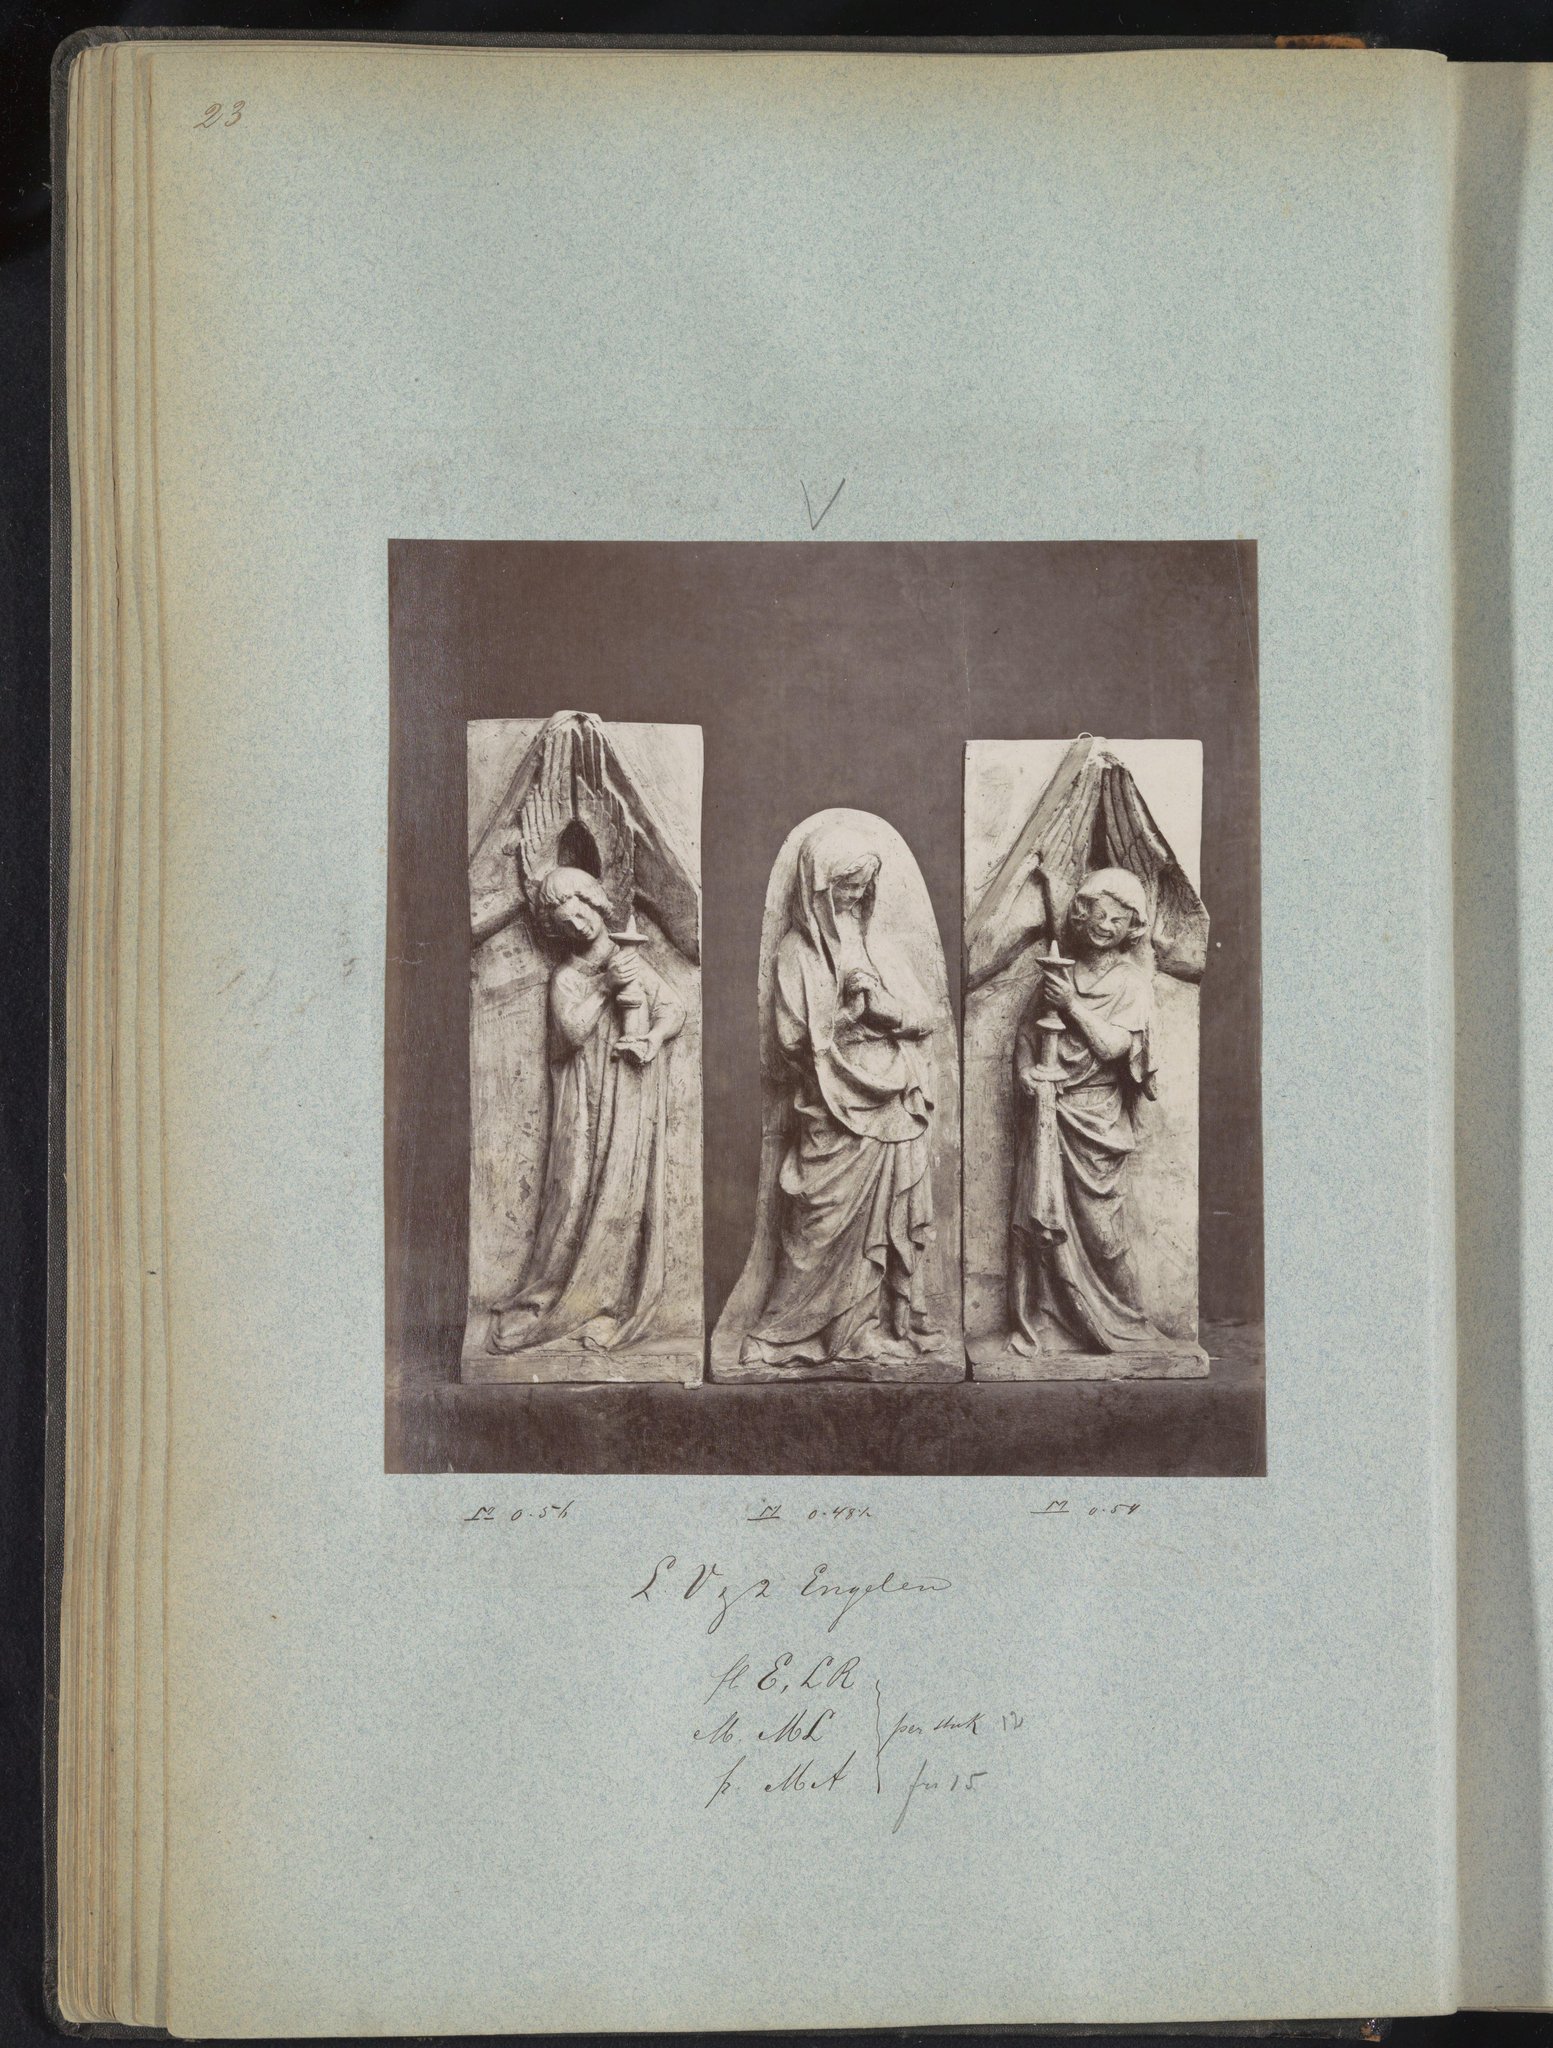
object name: album leaf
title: Drie sculpturen van engelen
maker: Anonymous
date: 1875-1900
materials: paper, photographic support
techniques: albumen print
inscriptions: annotation, annotation: ‘M 0.56 M 0.48 M 0.54’, annotation: ‘Engelen’